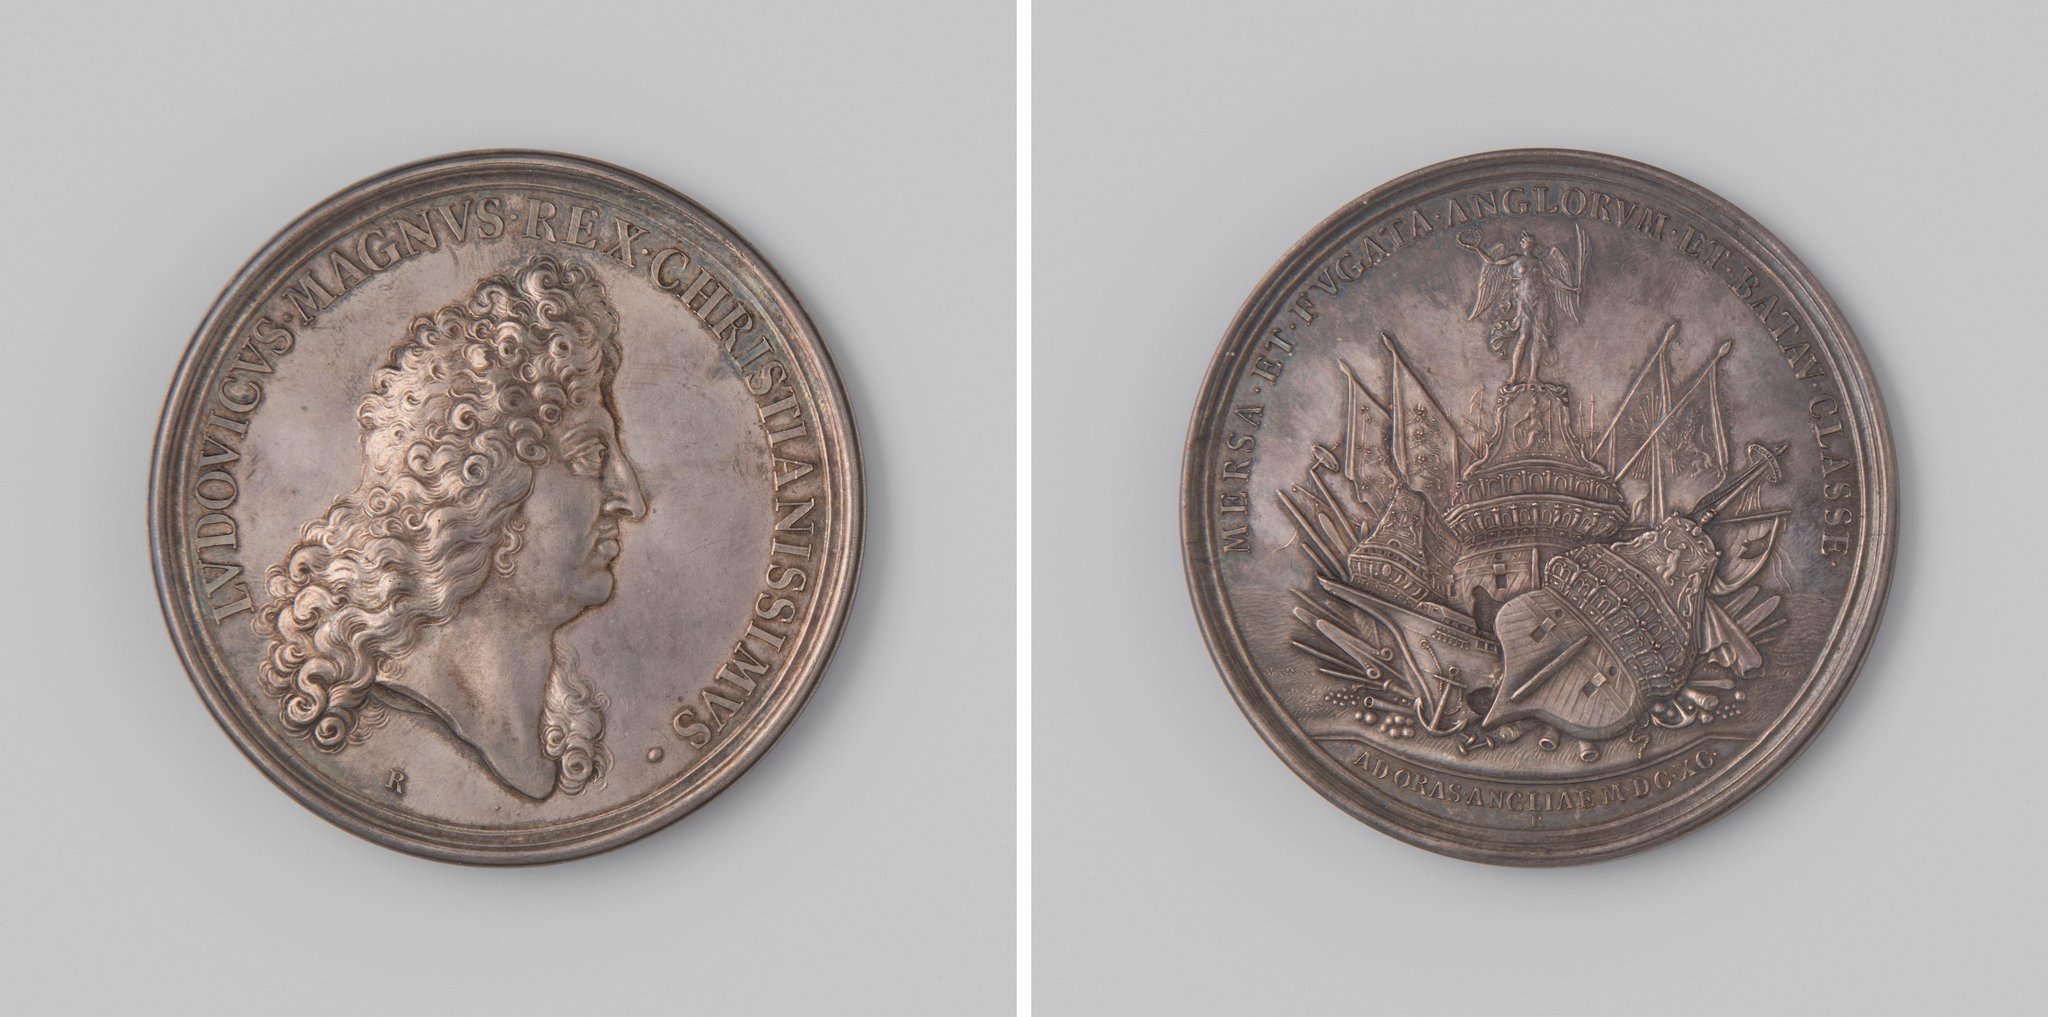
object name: history medal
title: Vernietiging van de Engelse en Nederlandse vloot bij Beachy Head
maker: jérôme roussel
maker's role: medailleur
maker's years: 1663-1713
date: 1690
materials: silver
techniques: striking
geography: paris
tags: lodewijk xiv (koning van frankrijk), battle of beachy head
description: Zilveren penning. Voorzijde: borststuk man binnen omschrift. Keerzijde: gevleugelde Overwinning met zegekrans staande op verschillende scheepswrakken binnen omschrift; afsnede: opschrift